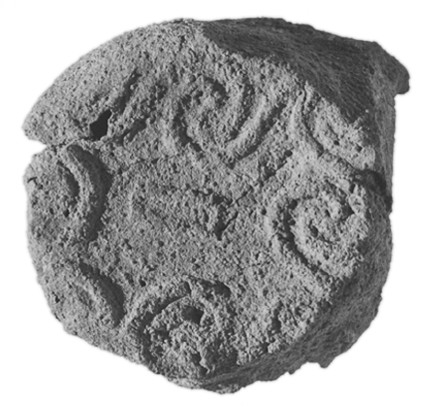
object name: sealing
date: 2030-1640 BCE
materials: clay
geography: egypt